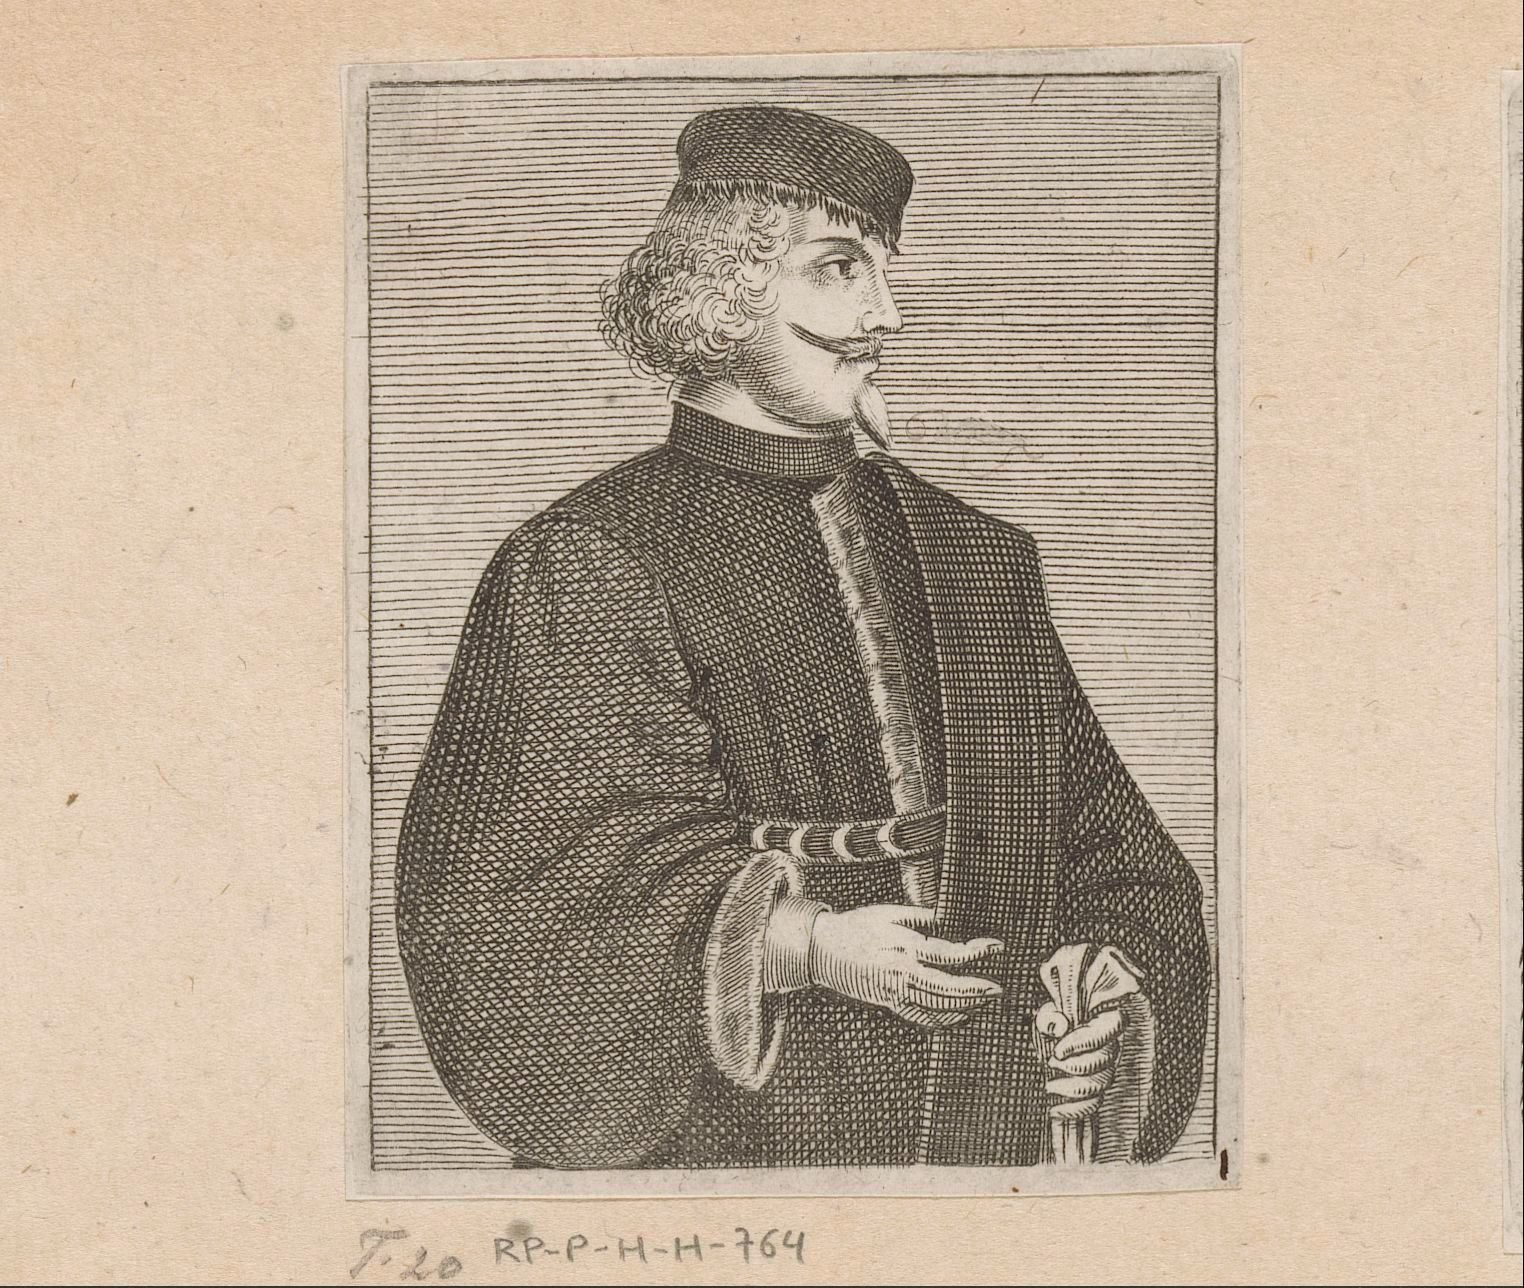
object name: print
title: Edelman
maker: francesco villamena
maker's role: draughtsman, painter, print maker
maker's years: 1566-1624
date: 1576-1624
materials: paper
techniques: engraving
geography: italy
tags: moustache, folk costume, regional costume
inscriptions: number: ‘1’, collector's mark: Lugt 11, collector's mark: Lugt 10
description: Een edelman met snor en sik, naar rechts gekeerd.